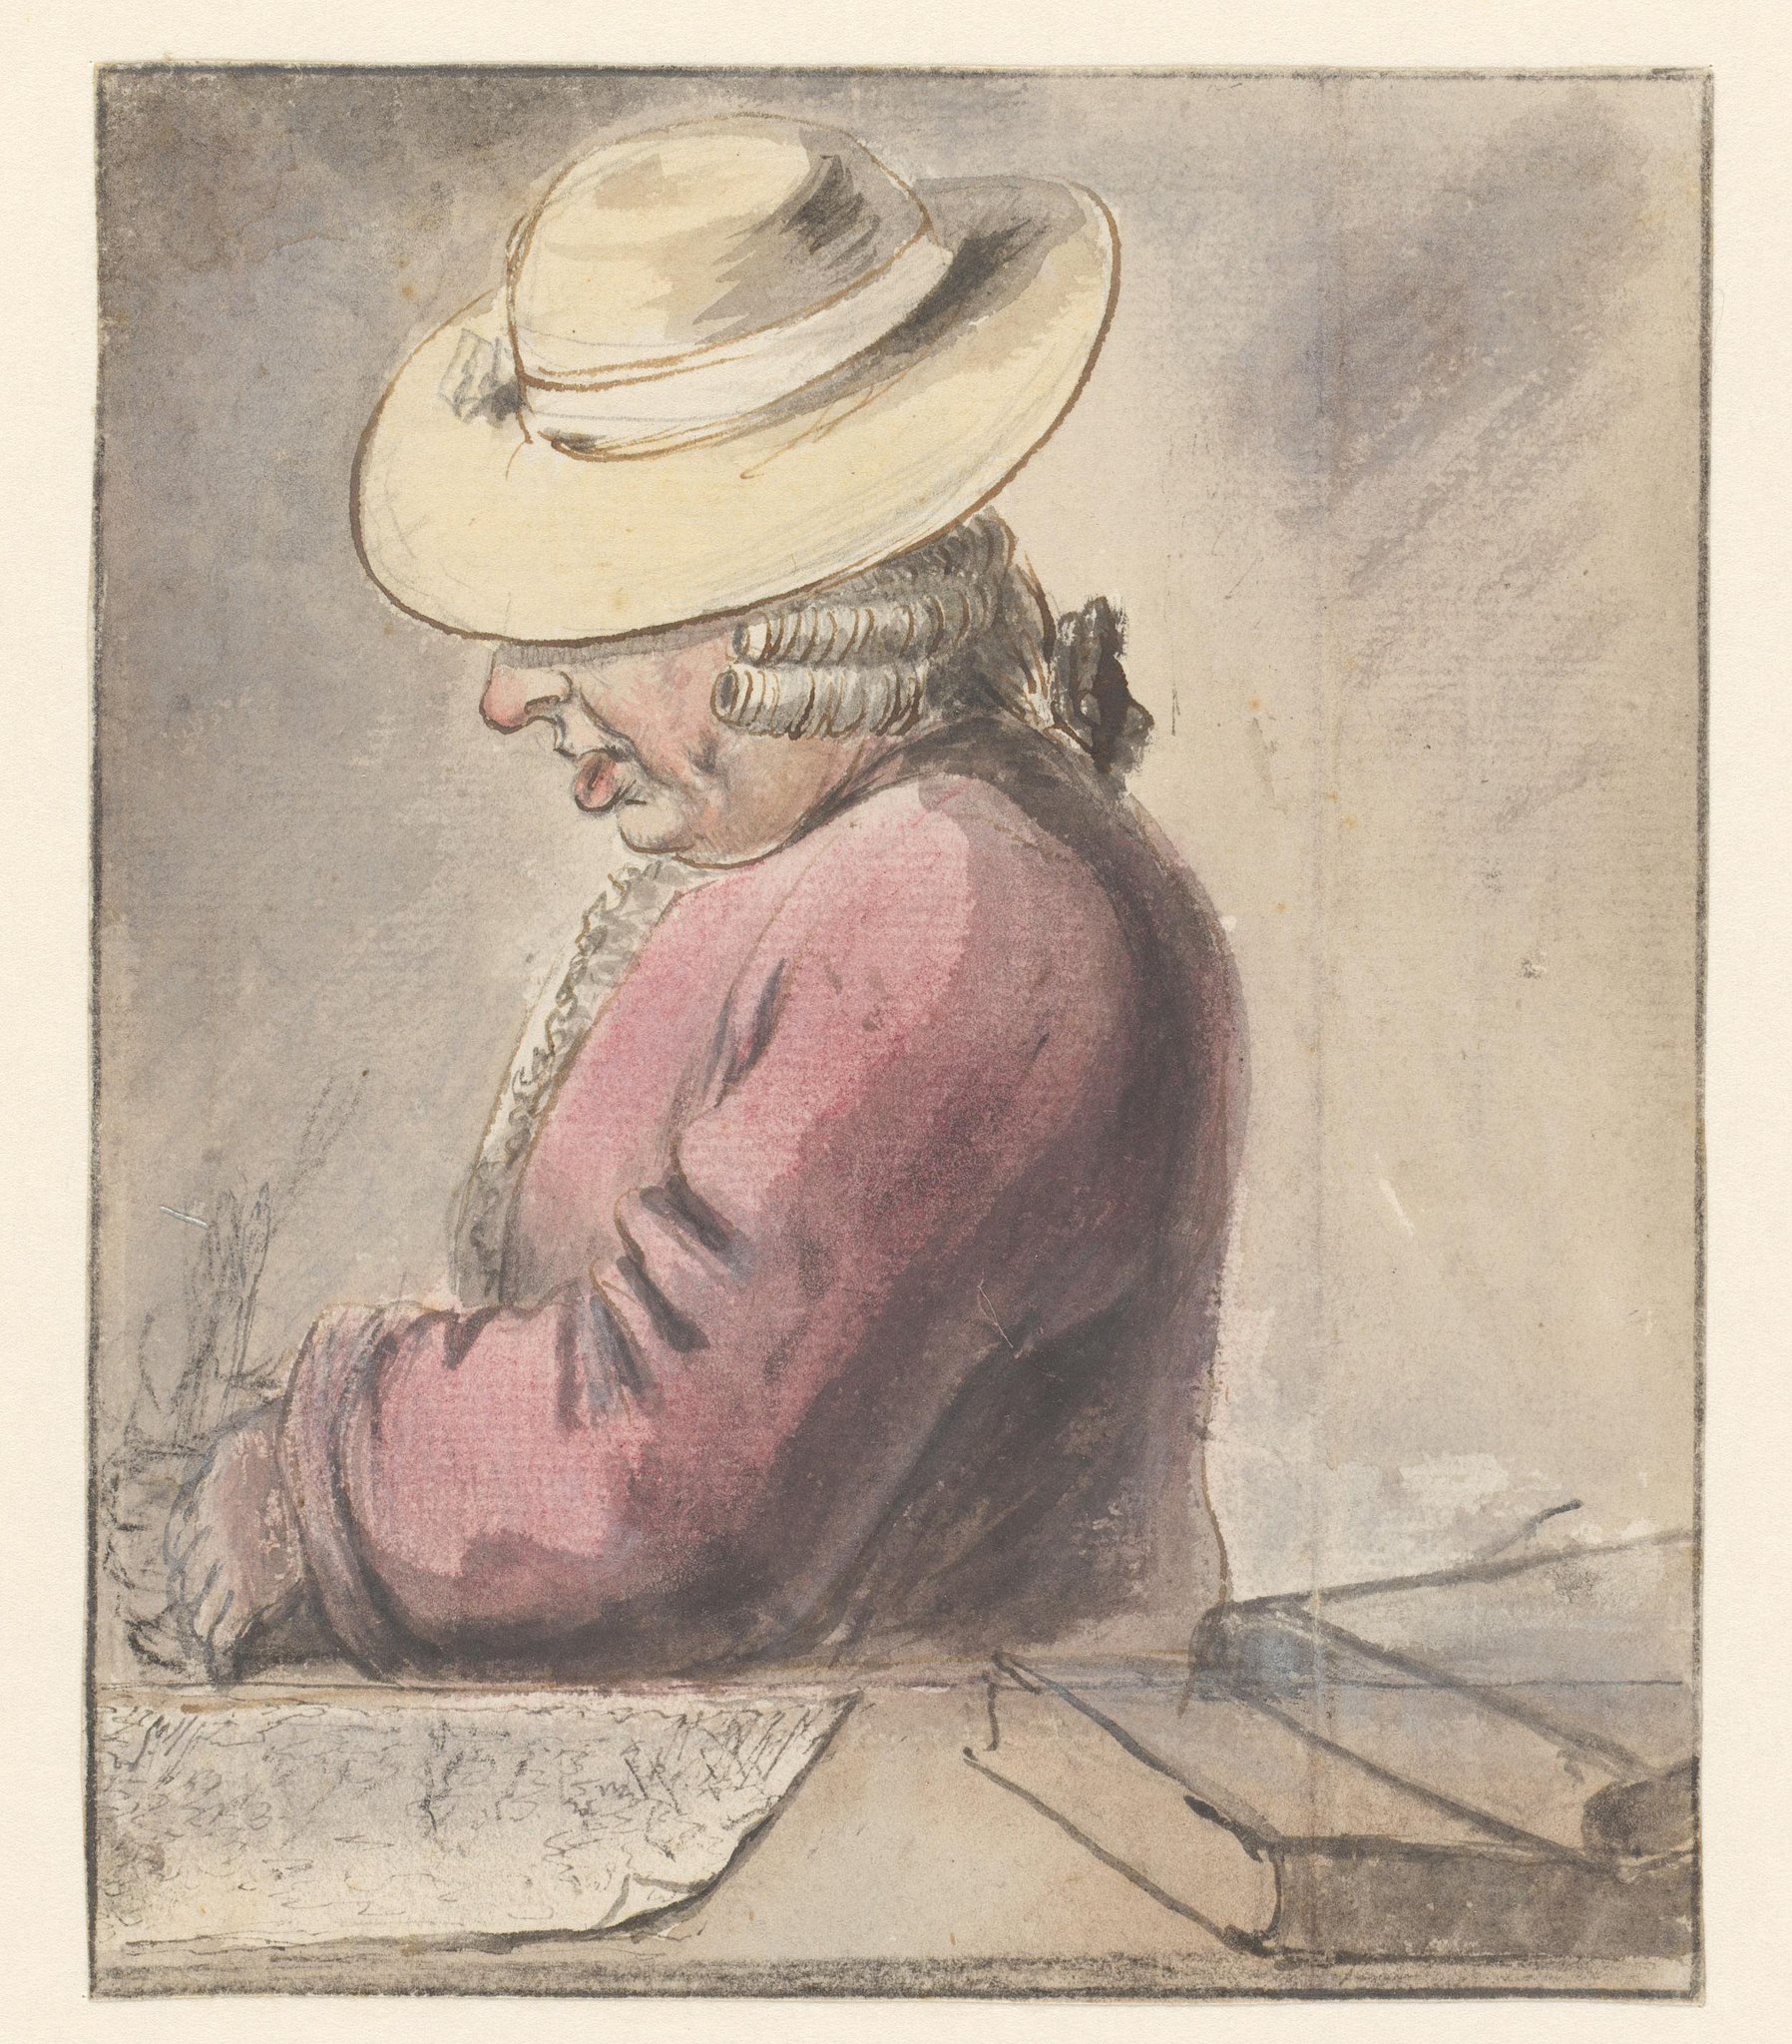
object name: watercolor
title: Portret van Johann Goll van Franckenstein, met hoed, naar links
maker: louis bernard coclers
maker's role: draughtsman, print maker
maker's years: 1741-1817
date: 1783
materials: paper, watercolor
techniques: brush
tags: johann goll van frankenstein (i), historical persons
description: Pendant van Portret van Maria Goll van Franckenstein I, inventarisnummer RP-T-1912-43 (?)